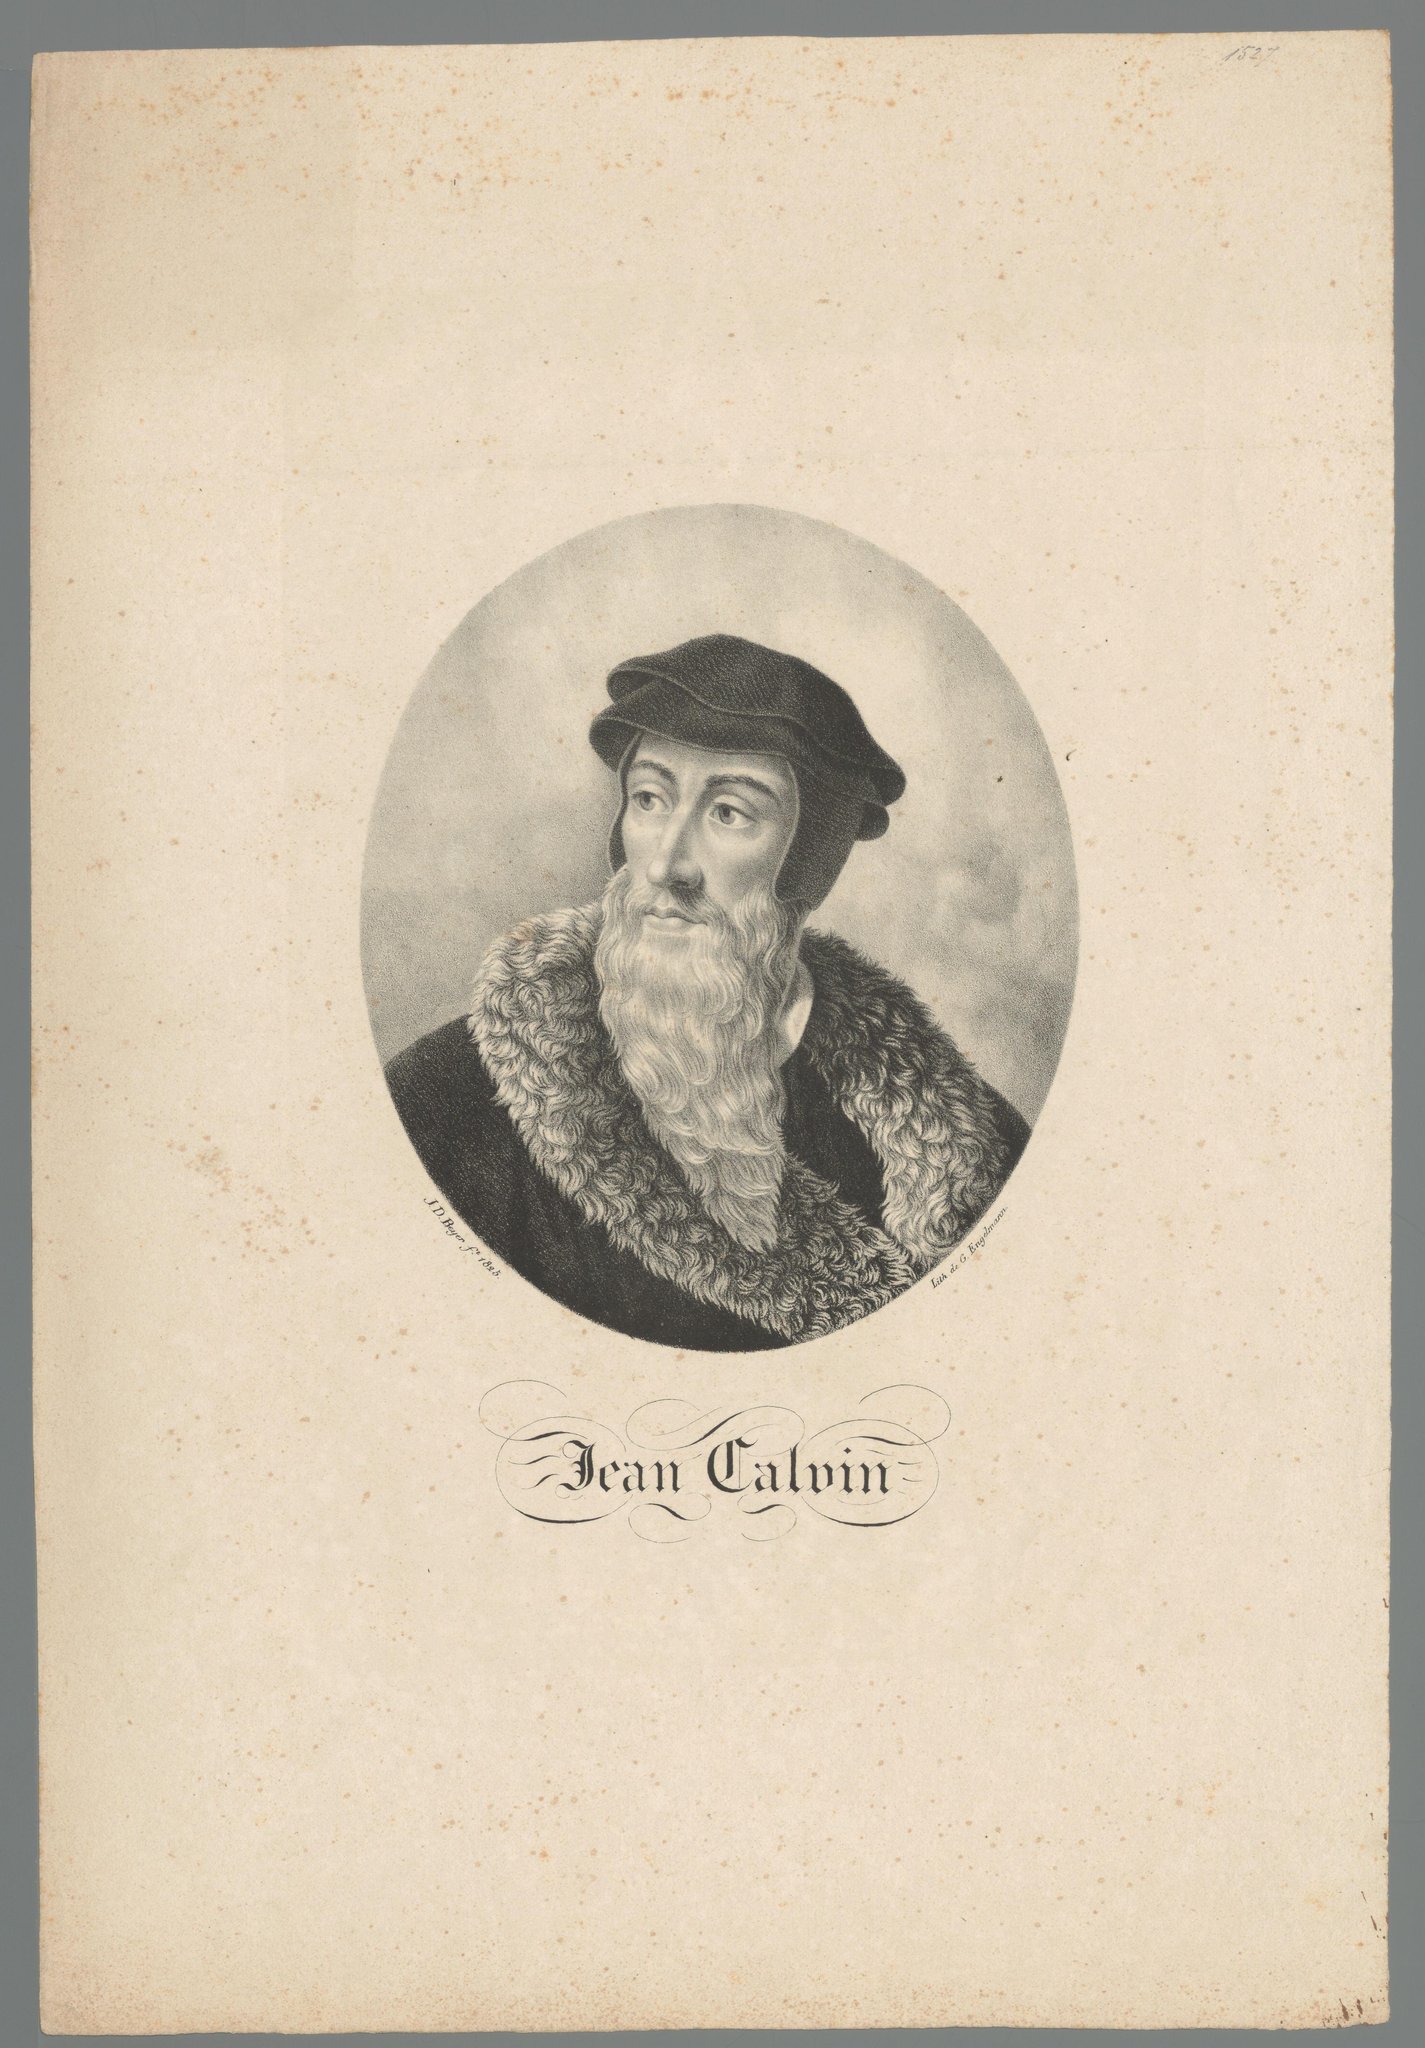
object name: print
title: Portret van Johannes Calvijn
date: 1825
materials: paper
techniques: lithograph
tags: adult man, historical persons, beard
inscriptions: collector's mark: Lugt 2228